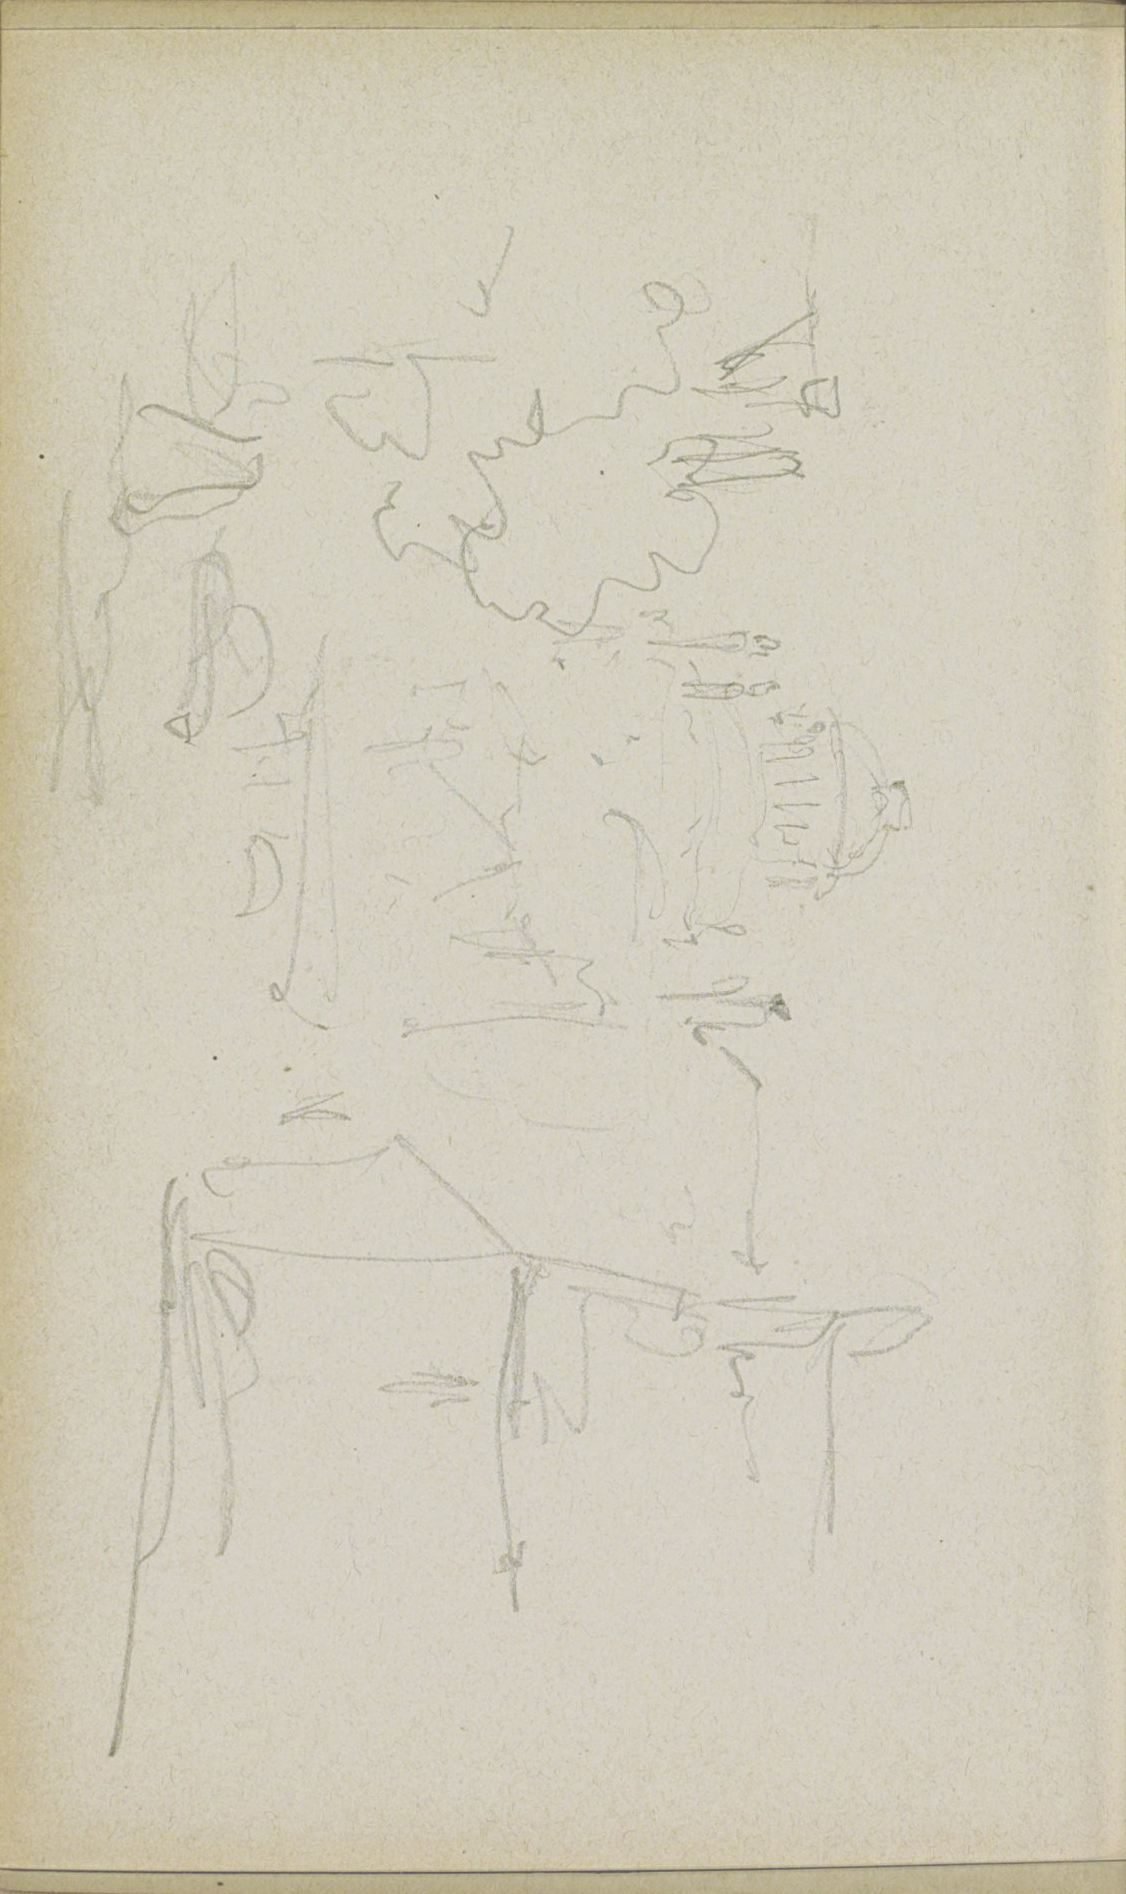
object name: sketchbook leaf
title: Gezicht op een straat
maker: adrianus eversen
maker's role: draughtsman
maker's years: 1818-1897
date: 1828-1897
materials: paper, pencil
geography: netherlands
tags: street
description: Gezicht op een straat. In de verte een gebouw met een koepel. Blad 33 verso uit een schetsboek met 69 bladen vervaardigd in de omgeving van Delft, Rotterdam, Oudewater en Harlingen.